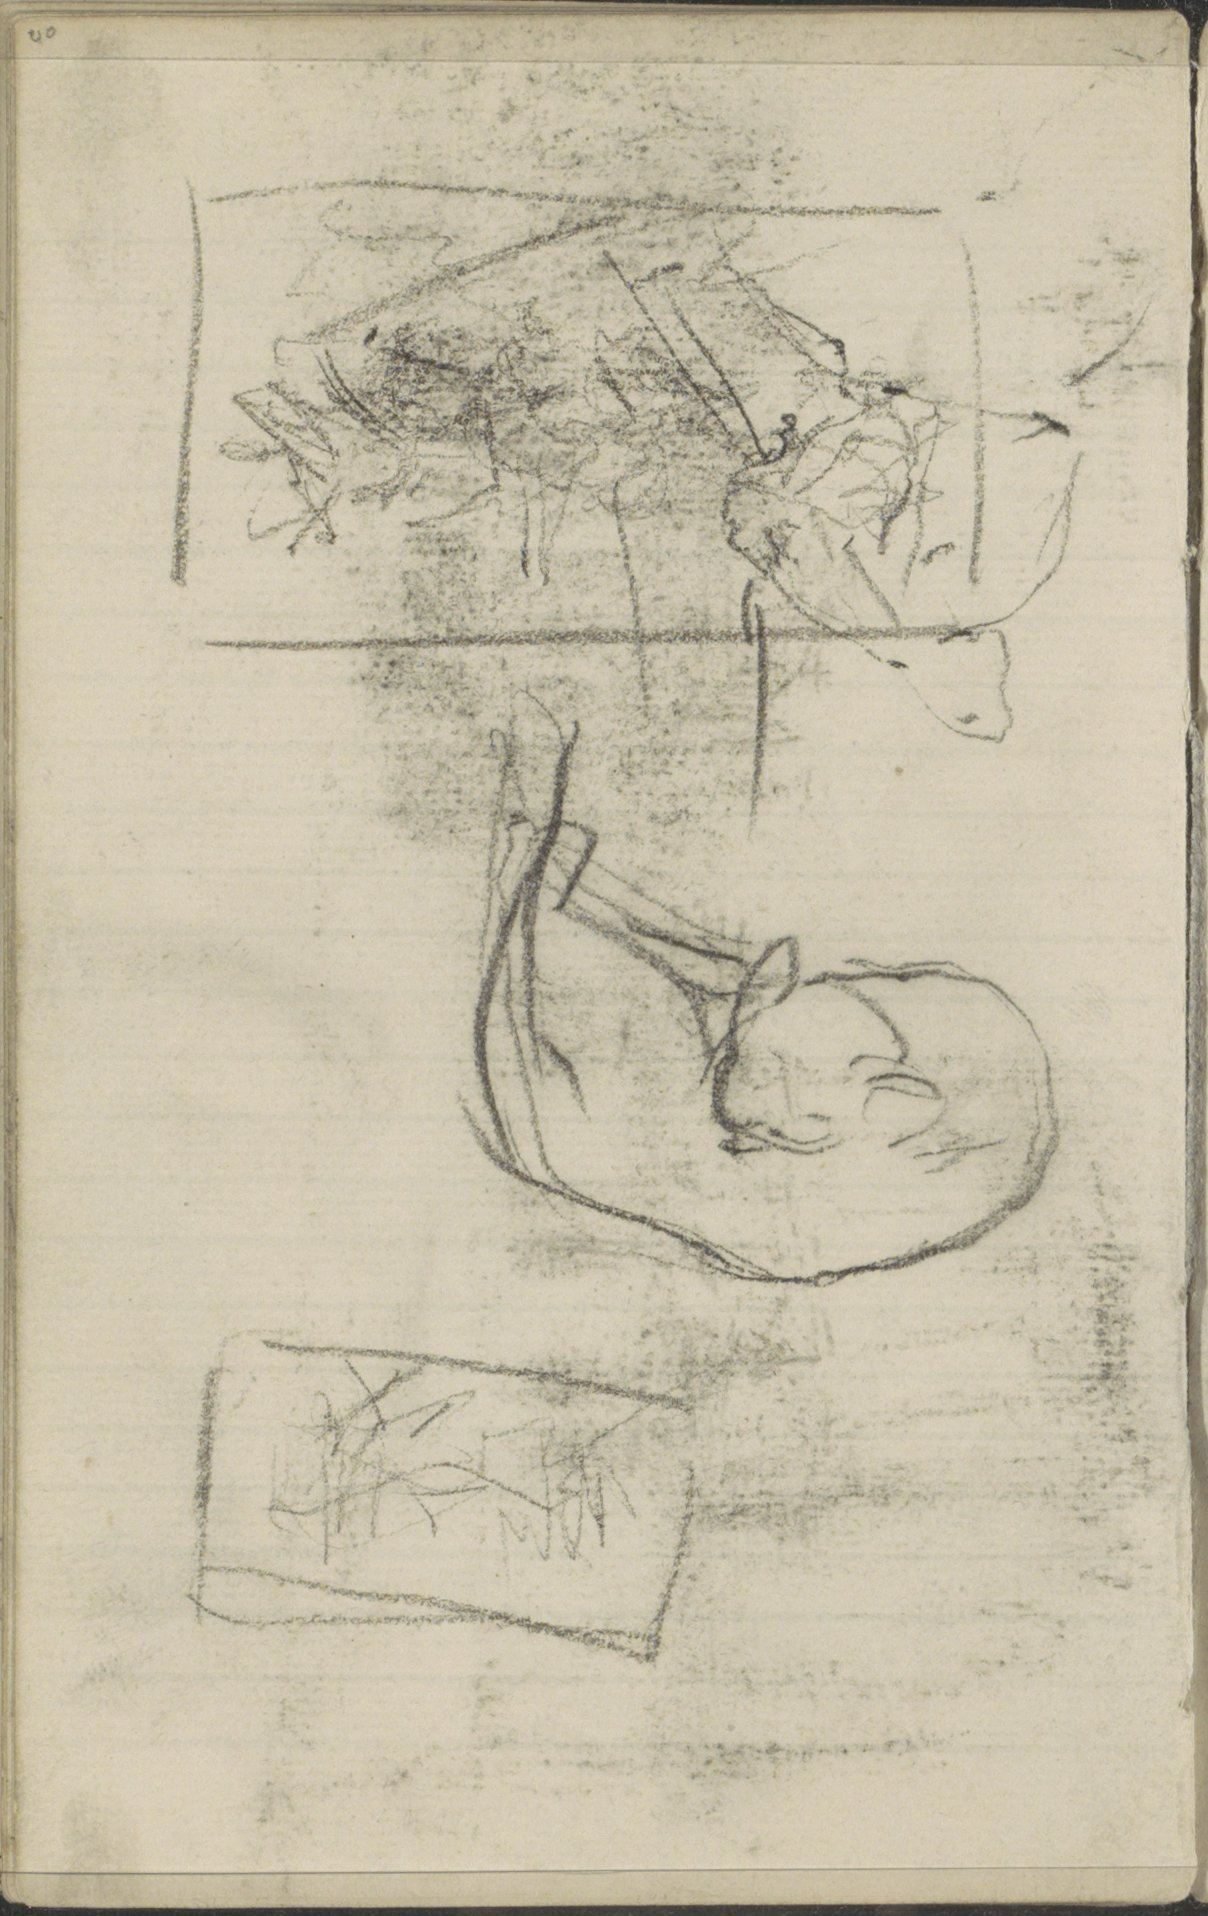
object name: sketchbook leaf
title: Studieblad, met onder andere een wassende kat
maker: marius bauer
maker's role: draughtsman, print maker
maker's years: 1867-1932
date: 1881-1885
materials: chalk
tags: cat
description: Tevens een studie van een kattenkop. Pagina 40 uit een schetsboek met 26 bladen.